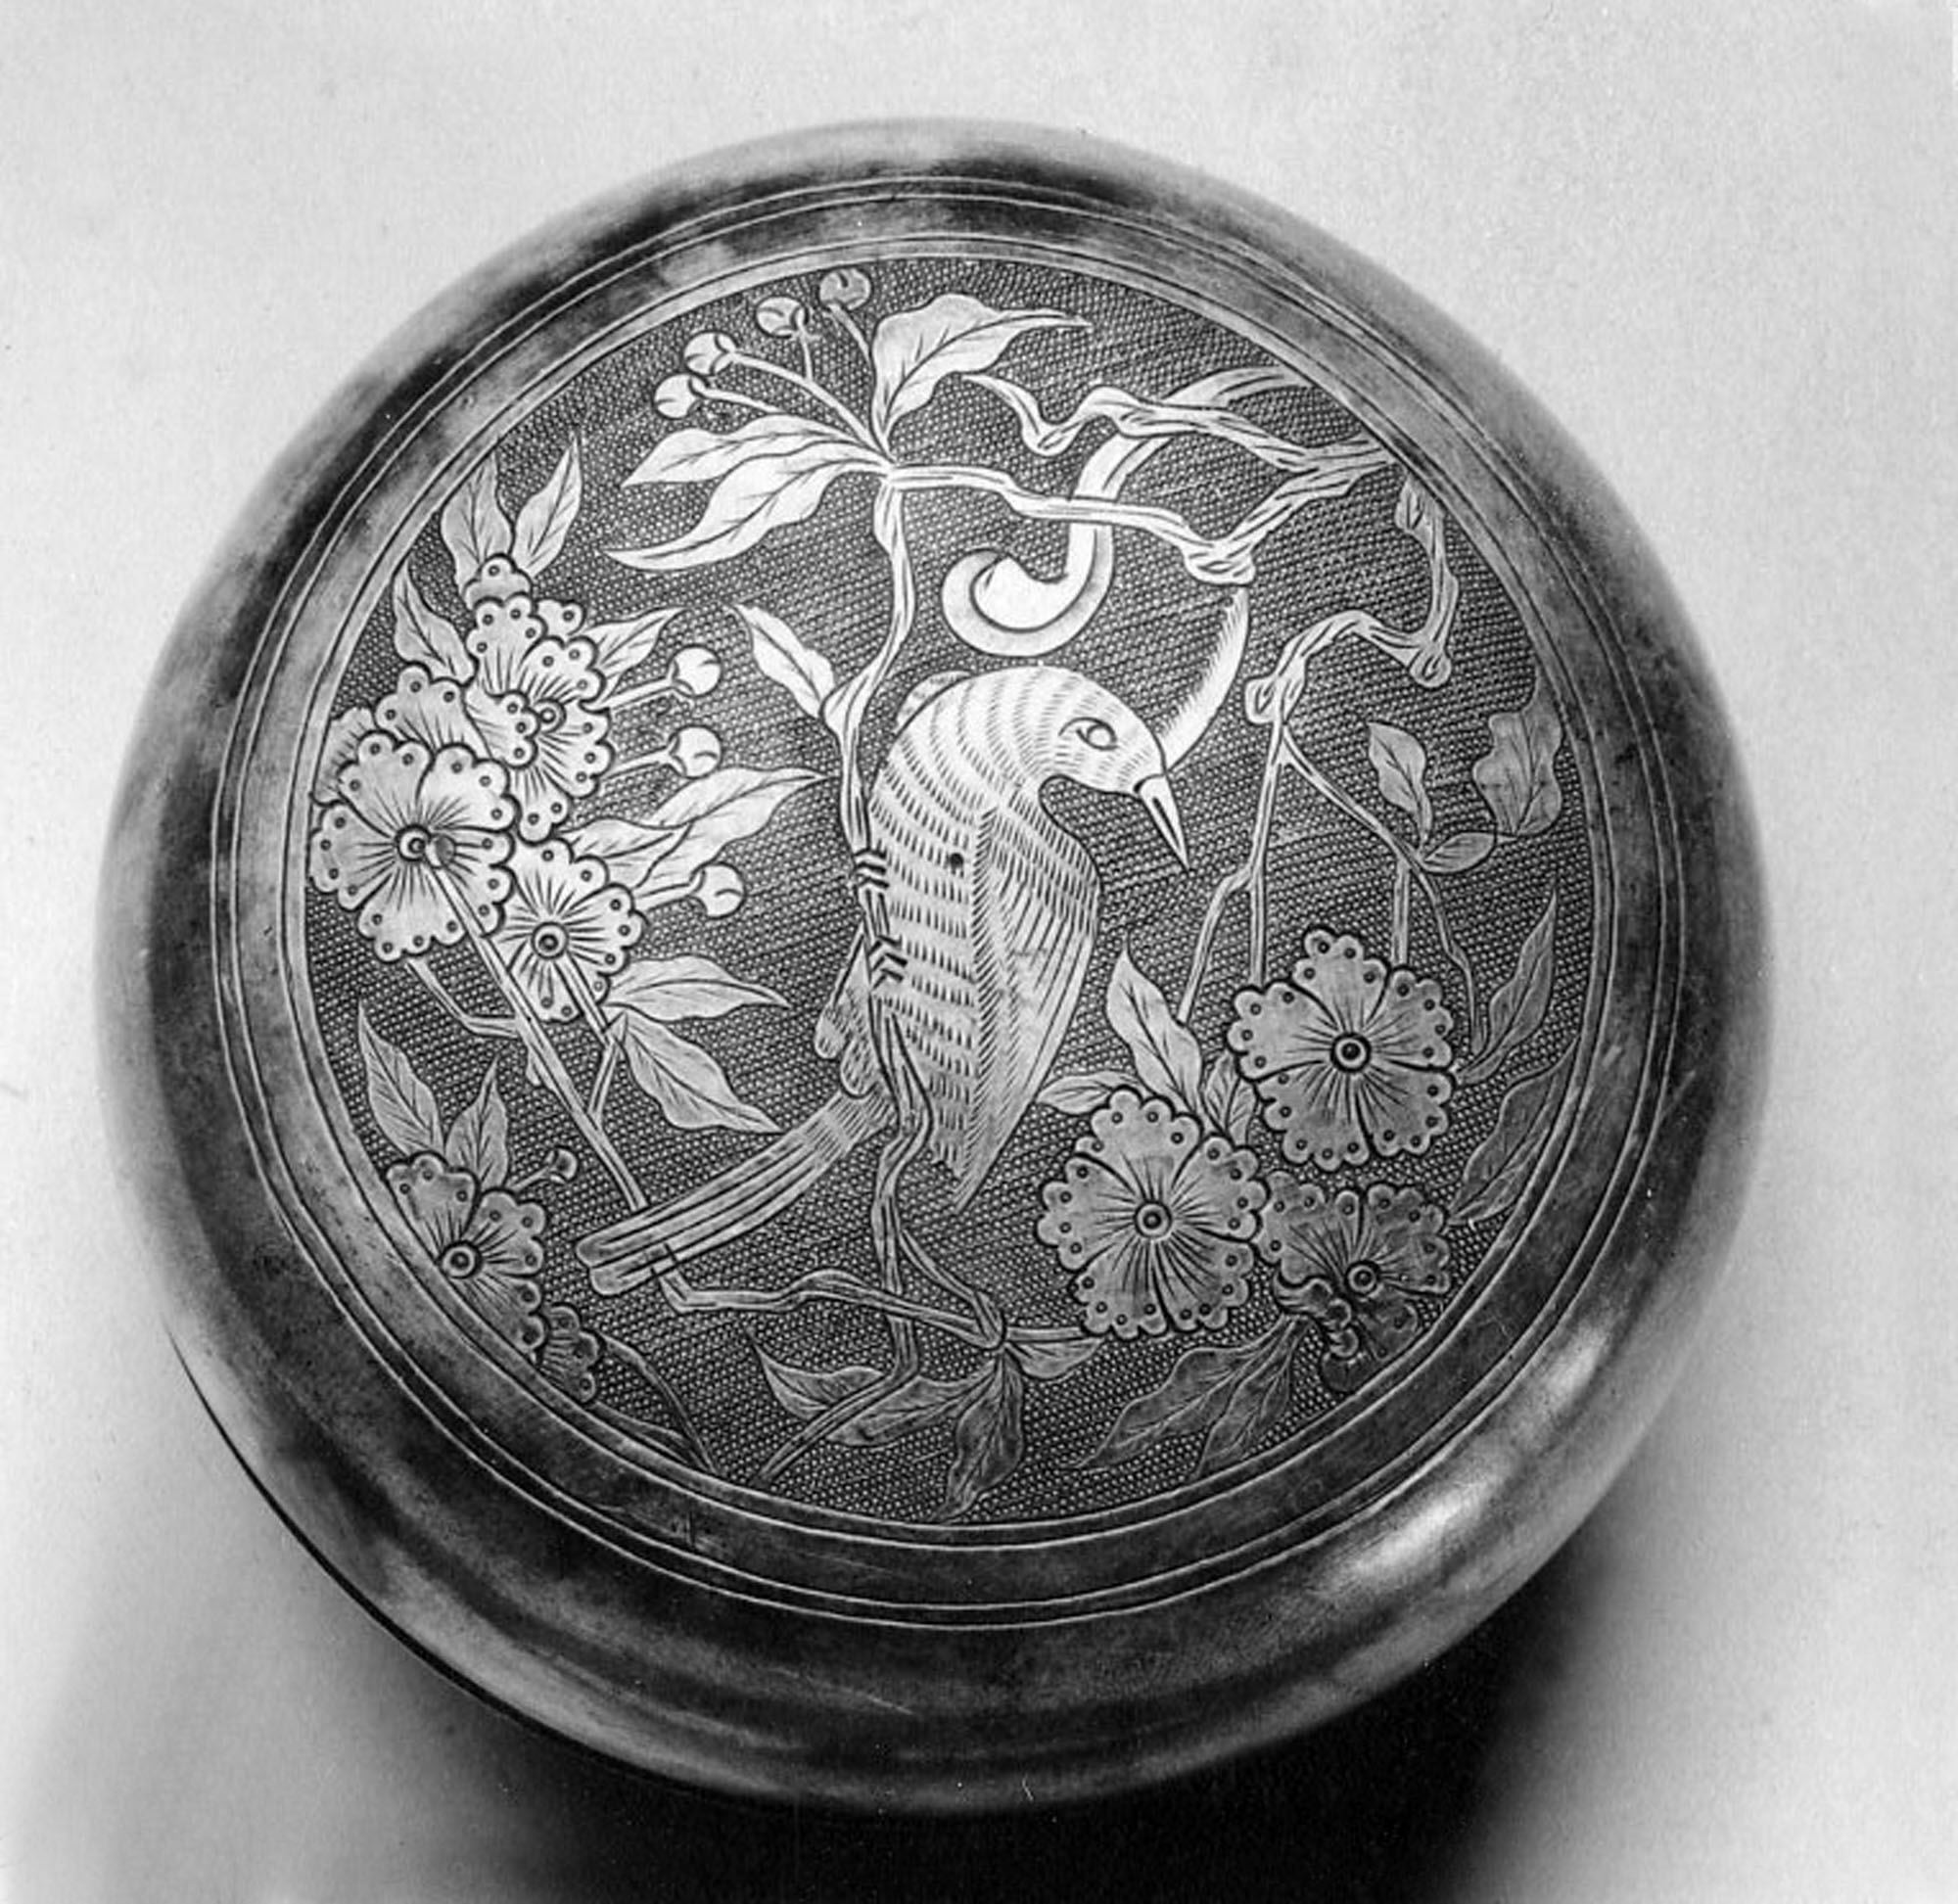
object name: covered box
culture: chinese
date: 960-1279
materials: silver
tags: flowers,leaves